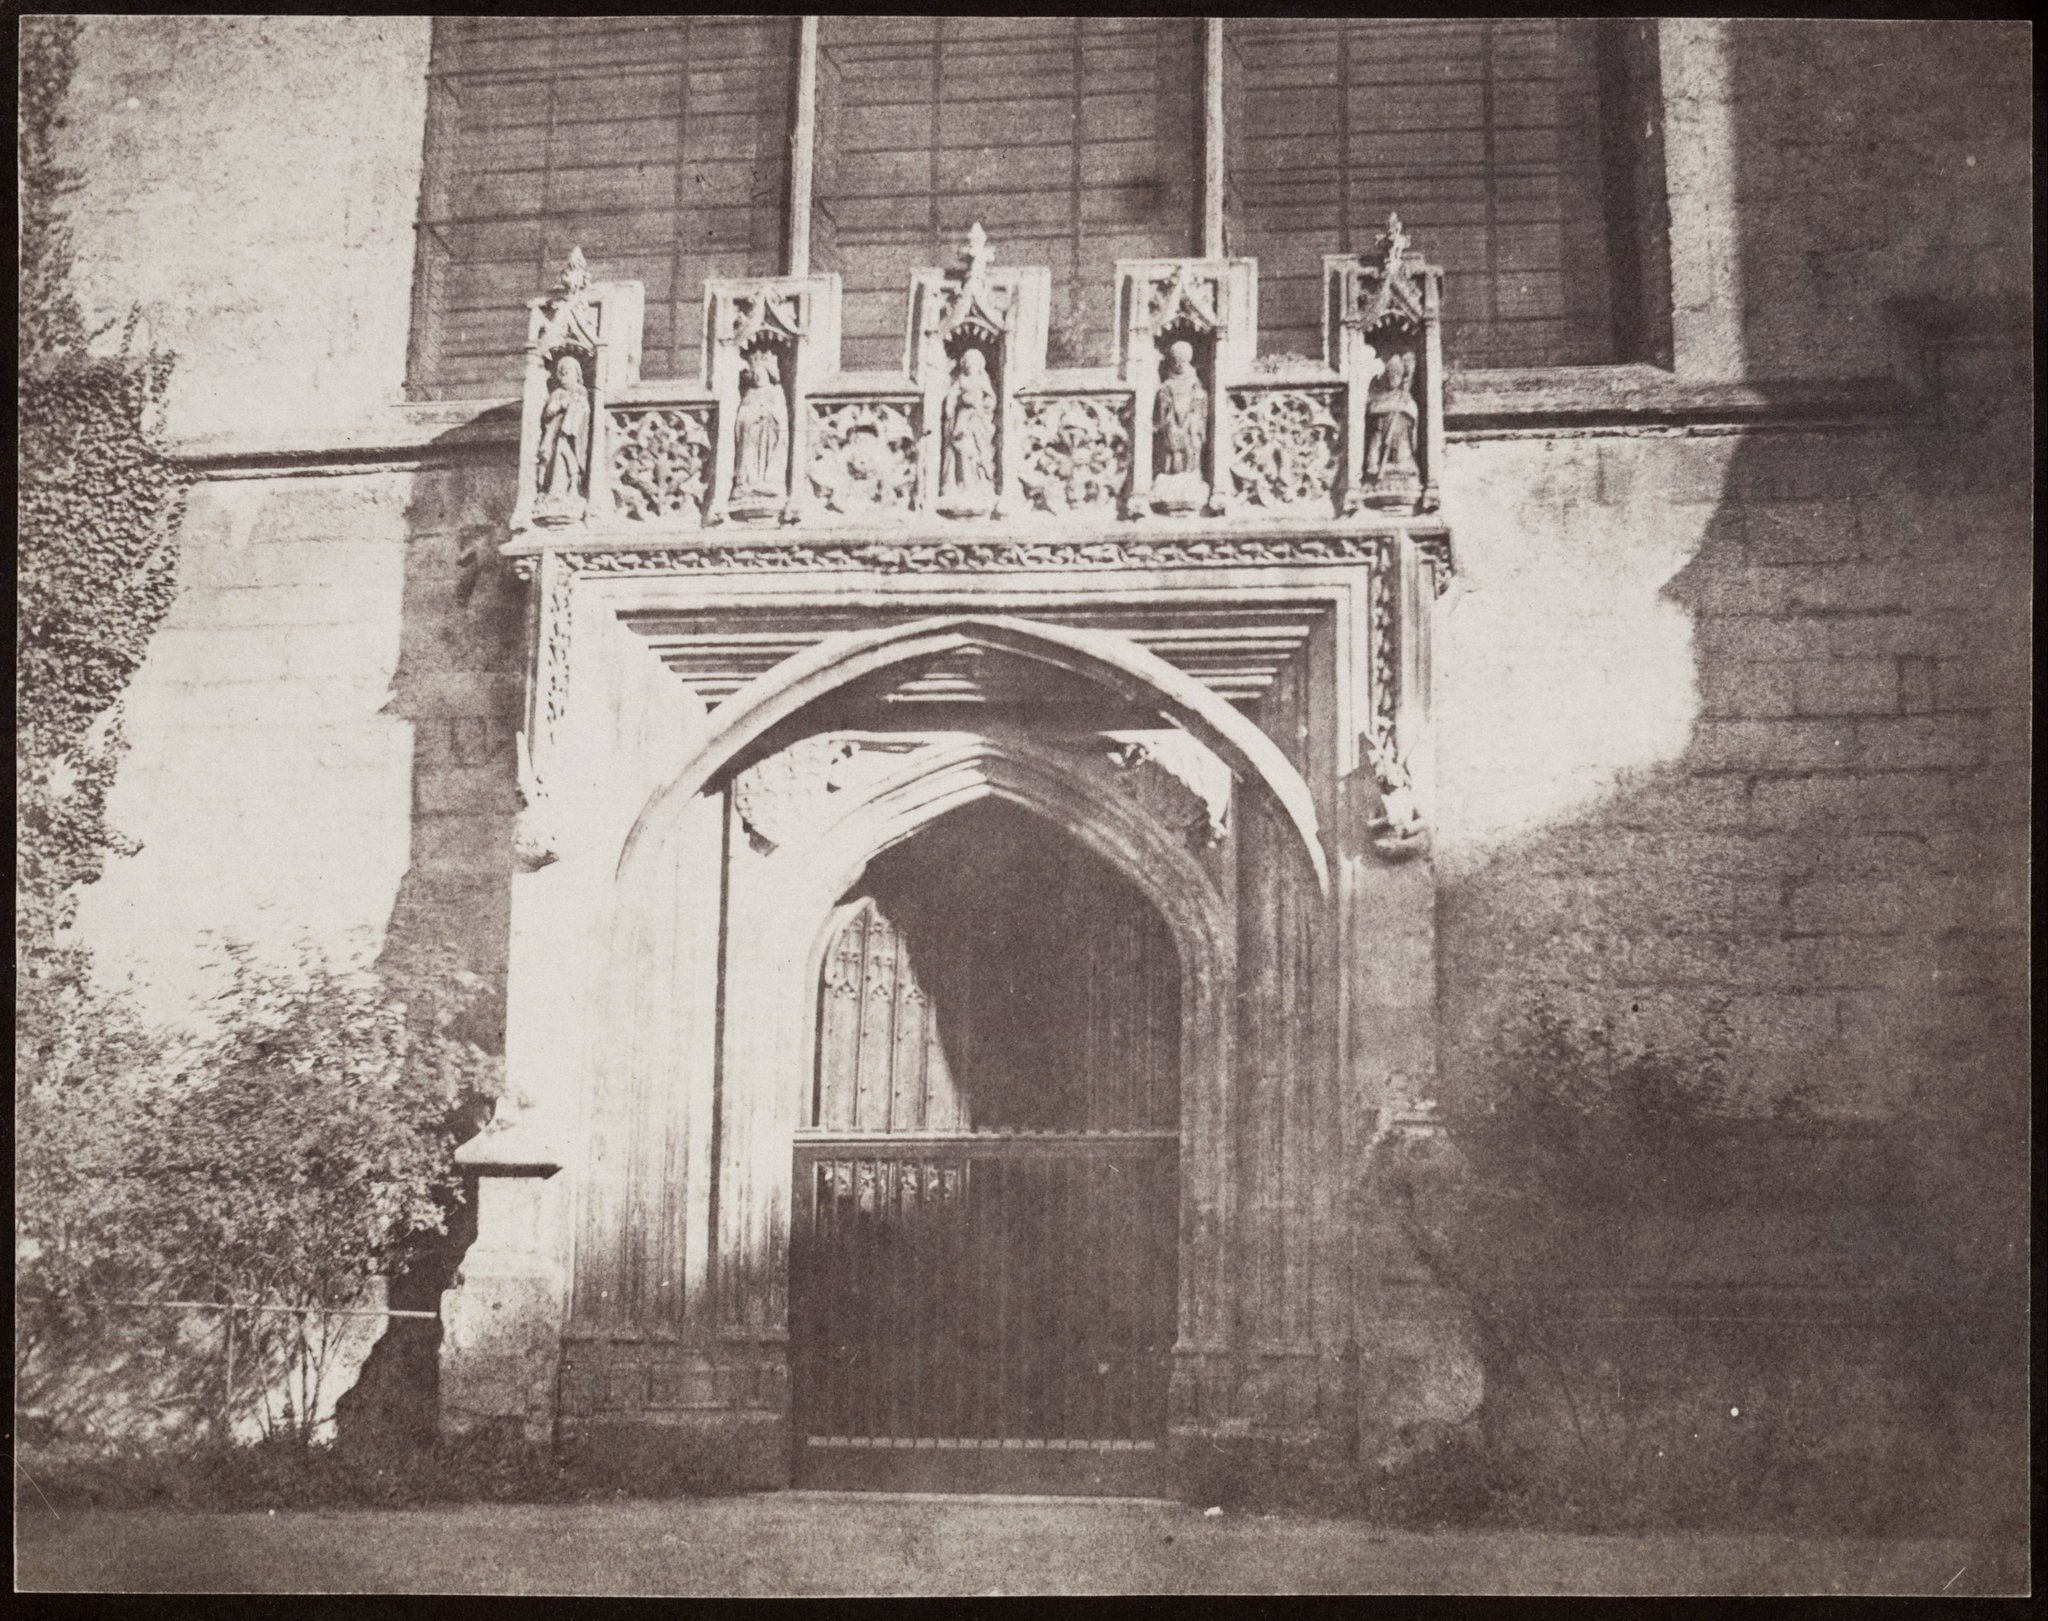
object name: photograph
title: Entrée van de Magdalen College Chapel in Oxford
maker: william henry fox talbot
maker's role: fotograaf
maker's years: 1800-1877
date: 1840-1850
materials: photographic support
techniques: salted paper print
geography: oxford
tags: closed door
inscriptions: number: ‘34/ A 32’